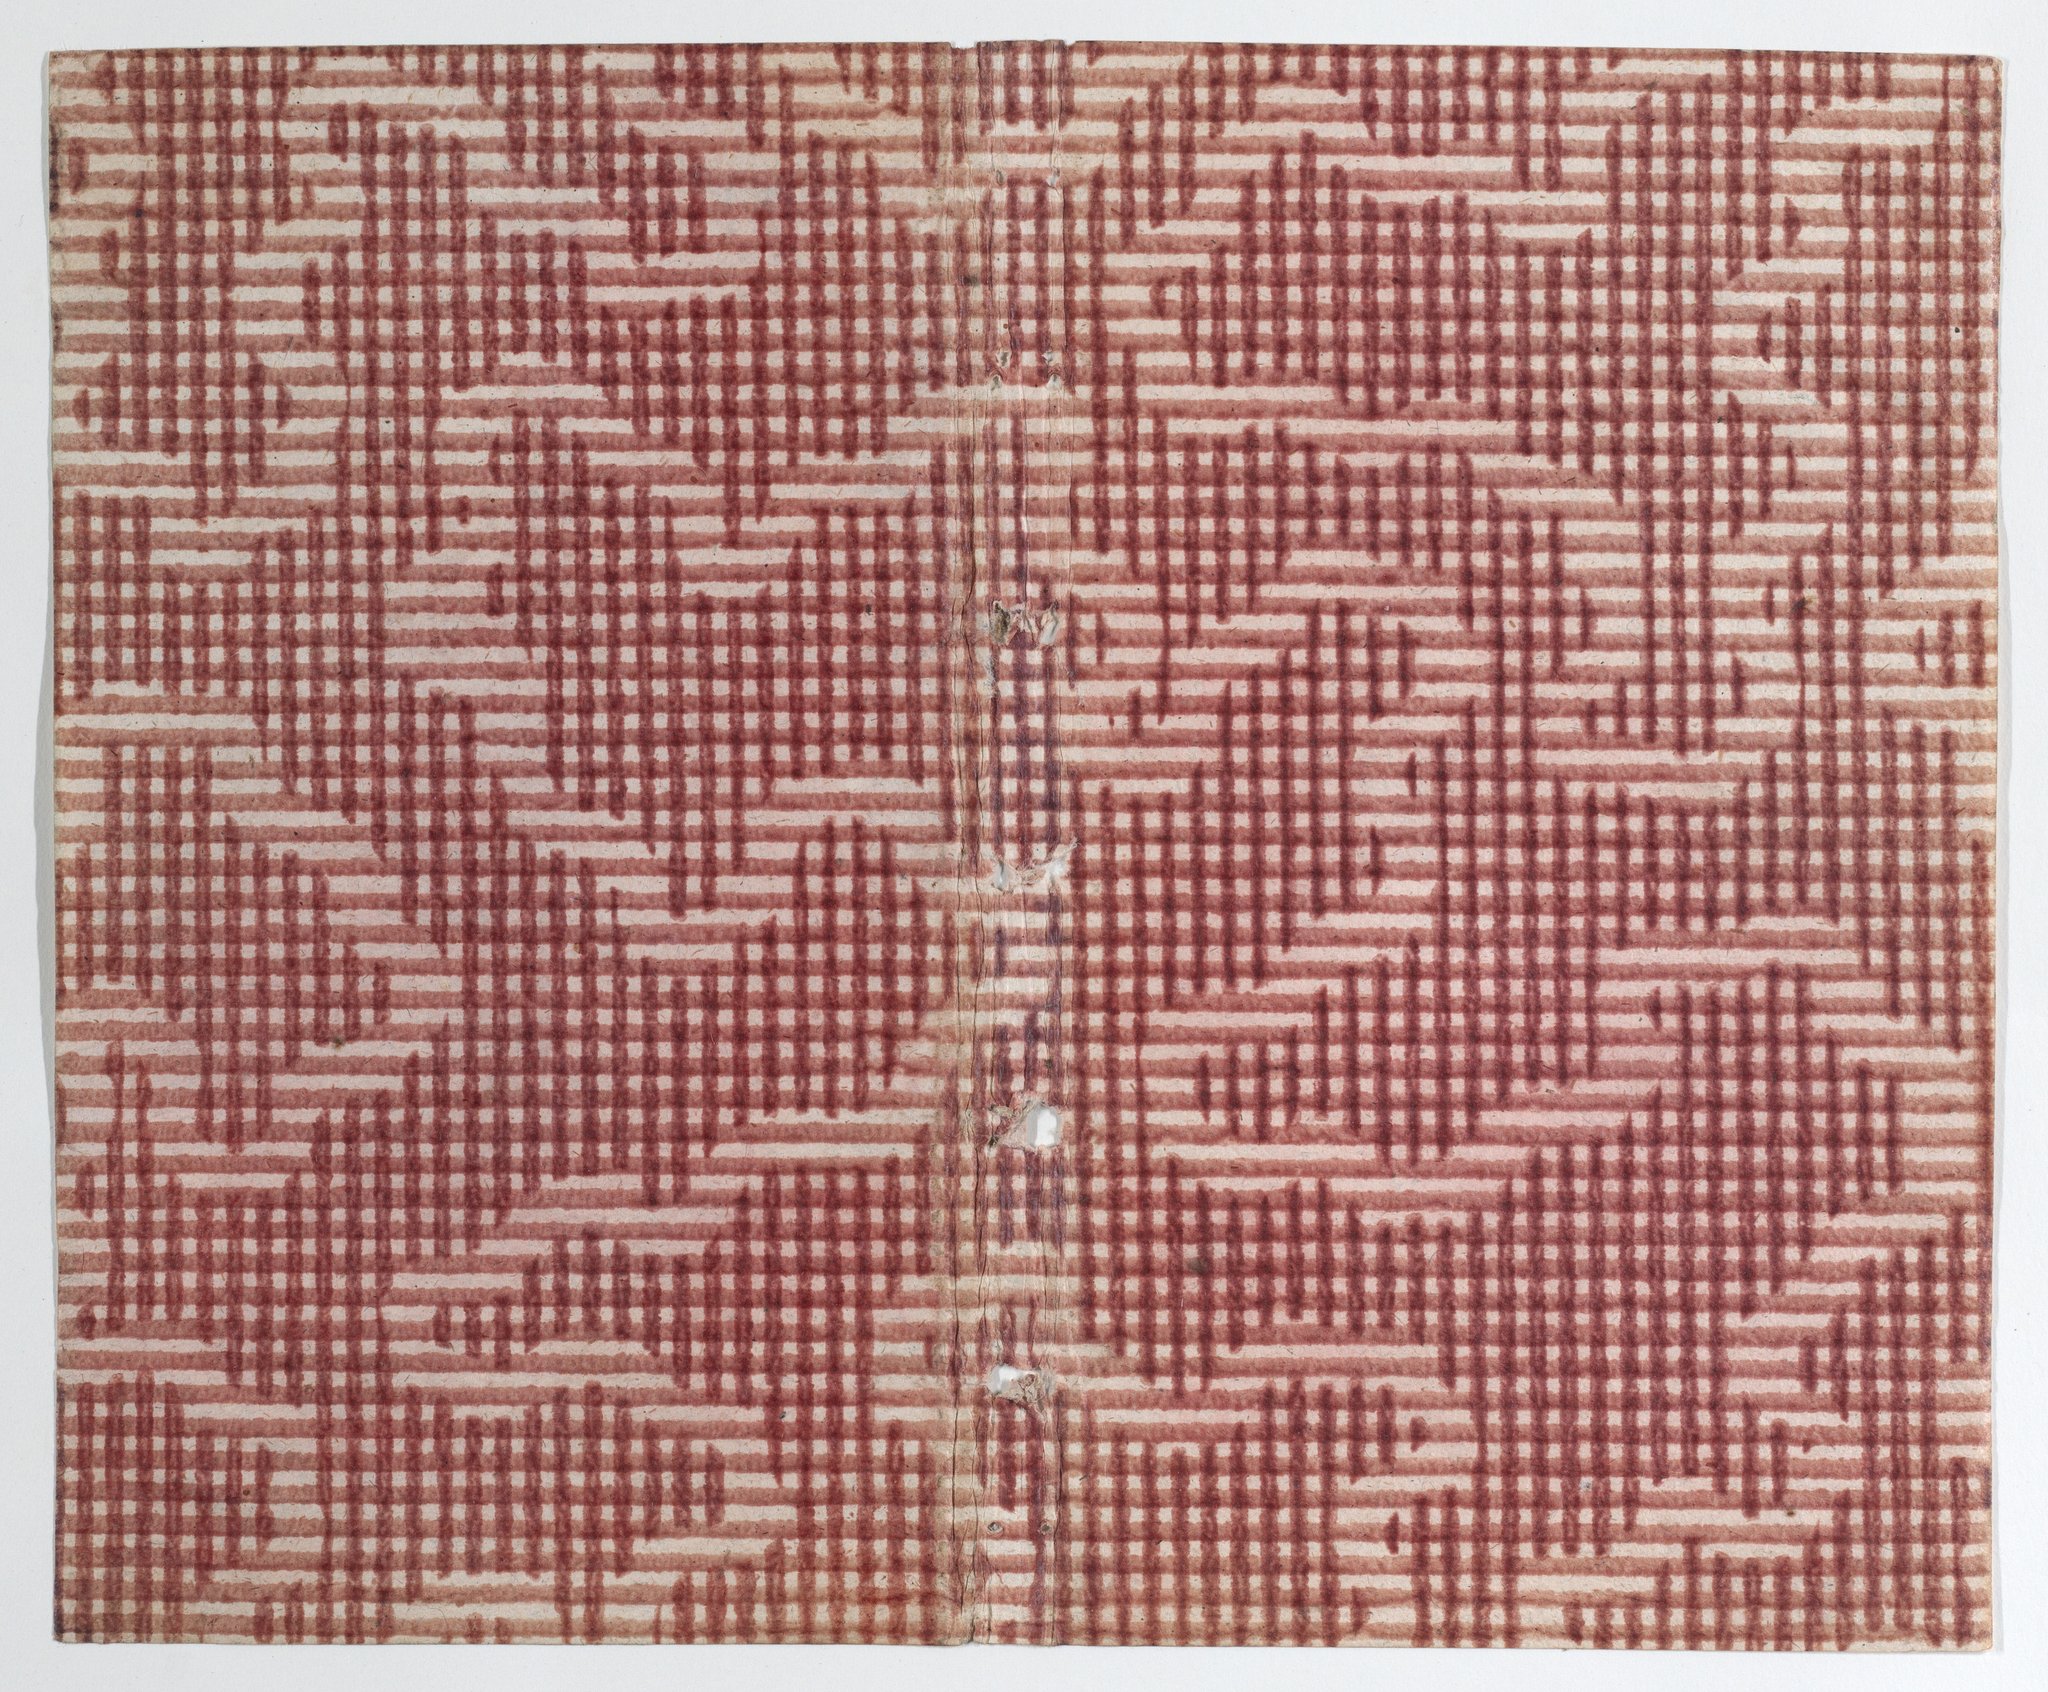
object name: print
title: Book cover with red crisscross and stripe pattern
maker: Anonymous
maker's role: artist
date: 1801-1900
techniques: relief print